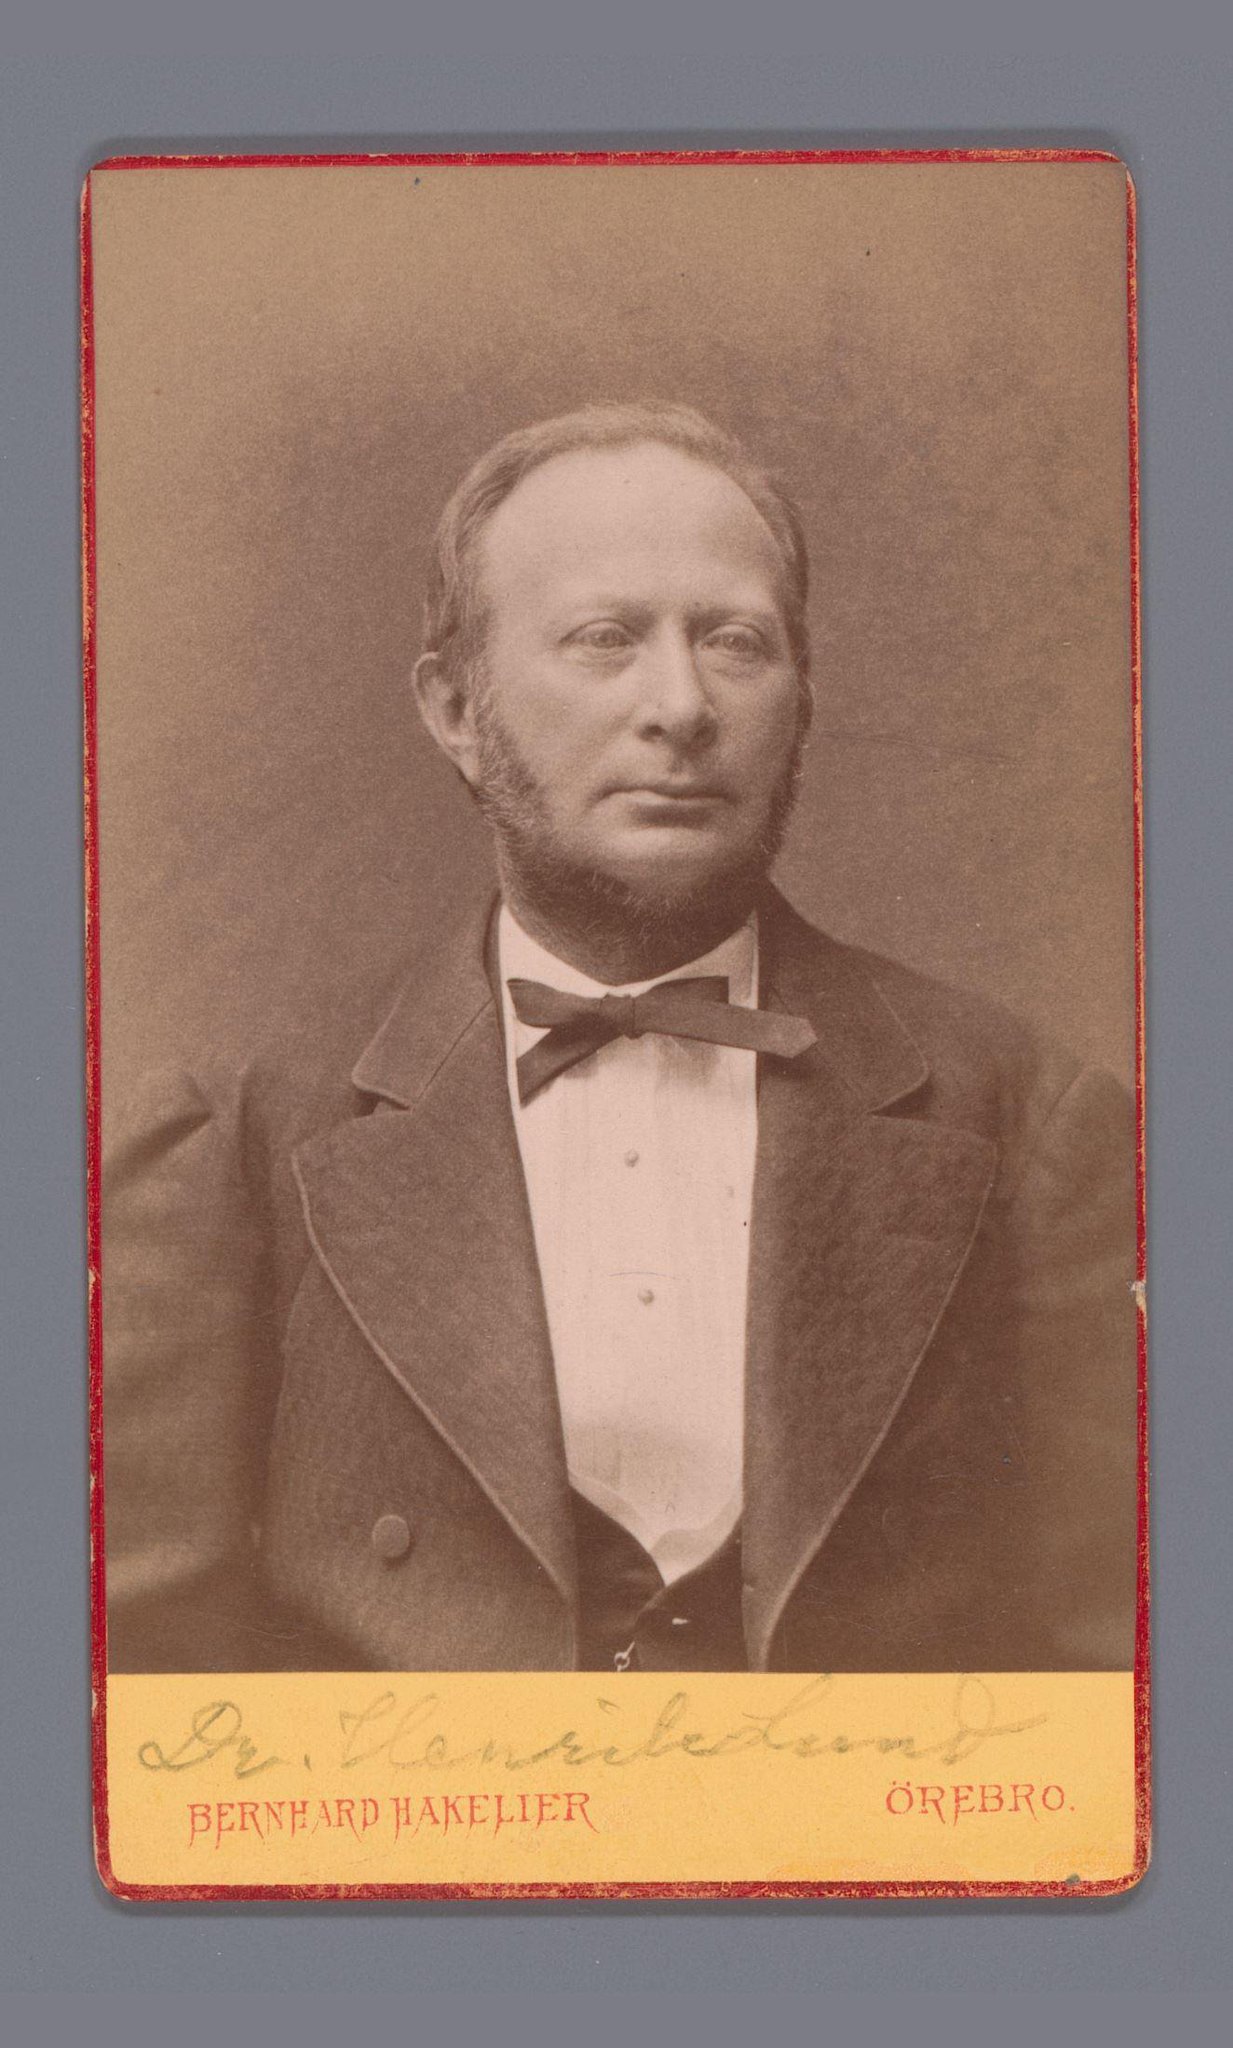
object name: carte de visite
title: Portret van een onbekende man, aangeduid als Dr. Henrikslund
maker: bernhard hakelier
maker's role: fotograaf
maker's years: 1848-1910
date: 1878-1890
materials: cardboard, paper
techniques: albumen print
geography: orebro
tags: adult man, historical persons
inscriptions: inscription: ‘FOTOGRAFI/ af/ Bernhard Hakelier./ ÖREBRO/ 130, C. Nygatan 130, C./ f.d. Falks gård./ Större antal af samma sort kan erhållas om Requisi-/tion insändes till Ateliern./ F. & K.’, inscription: ‘Dr. Henrikslund’